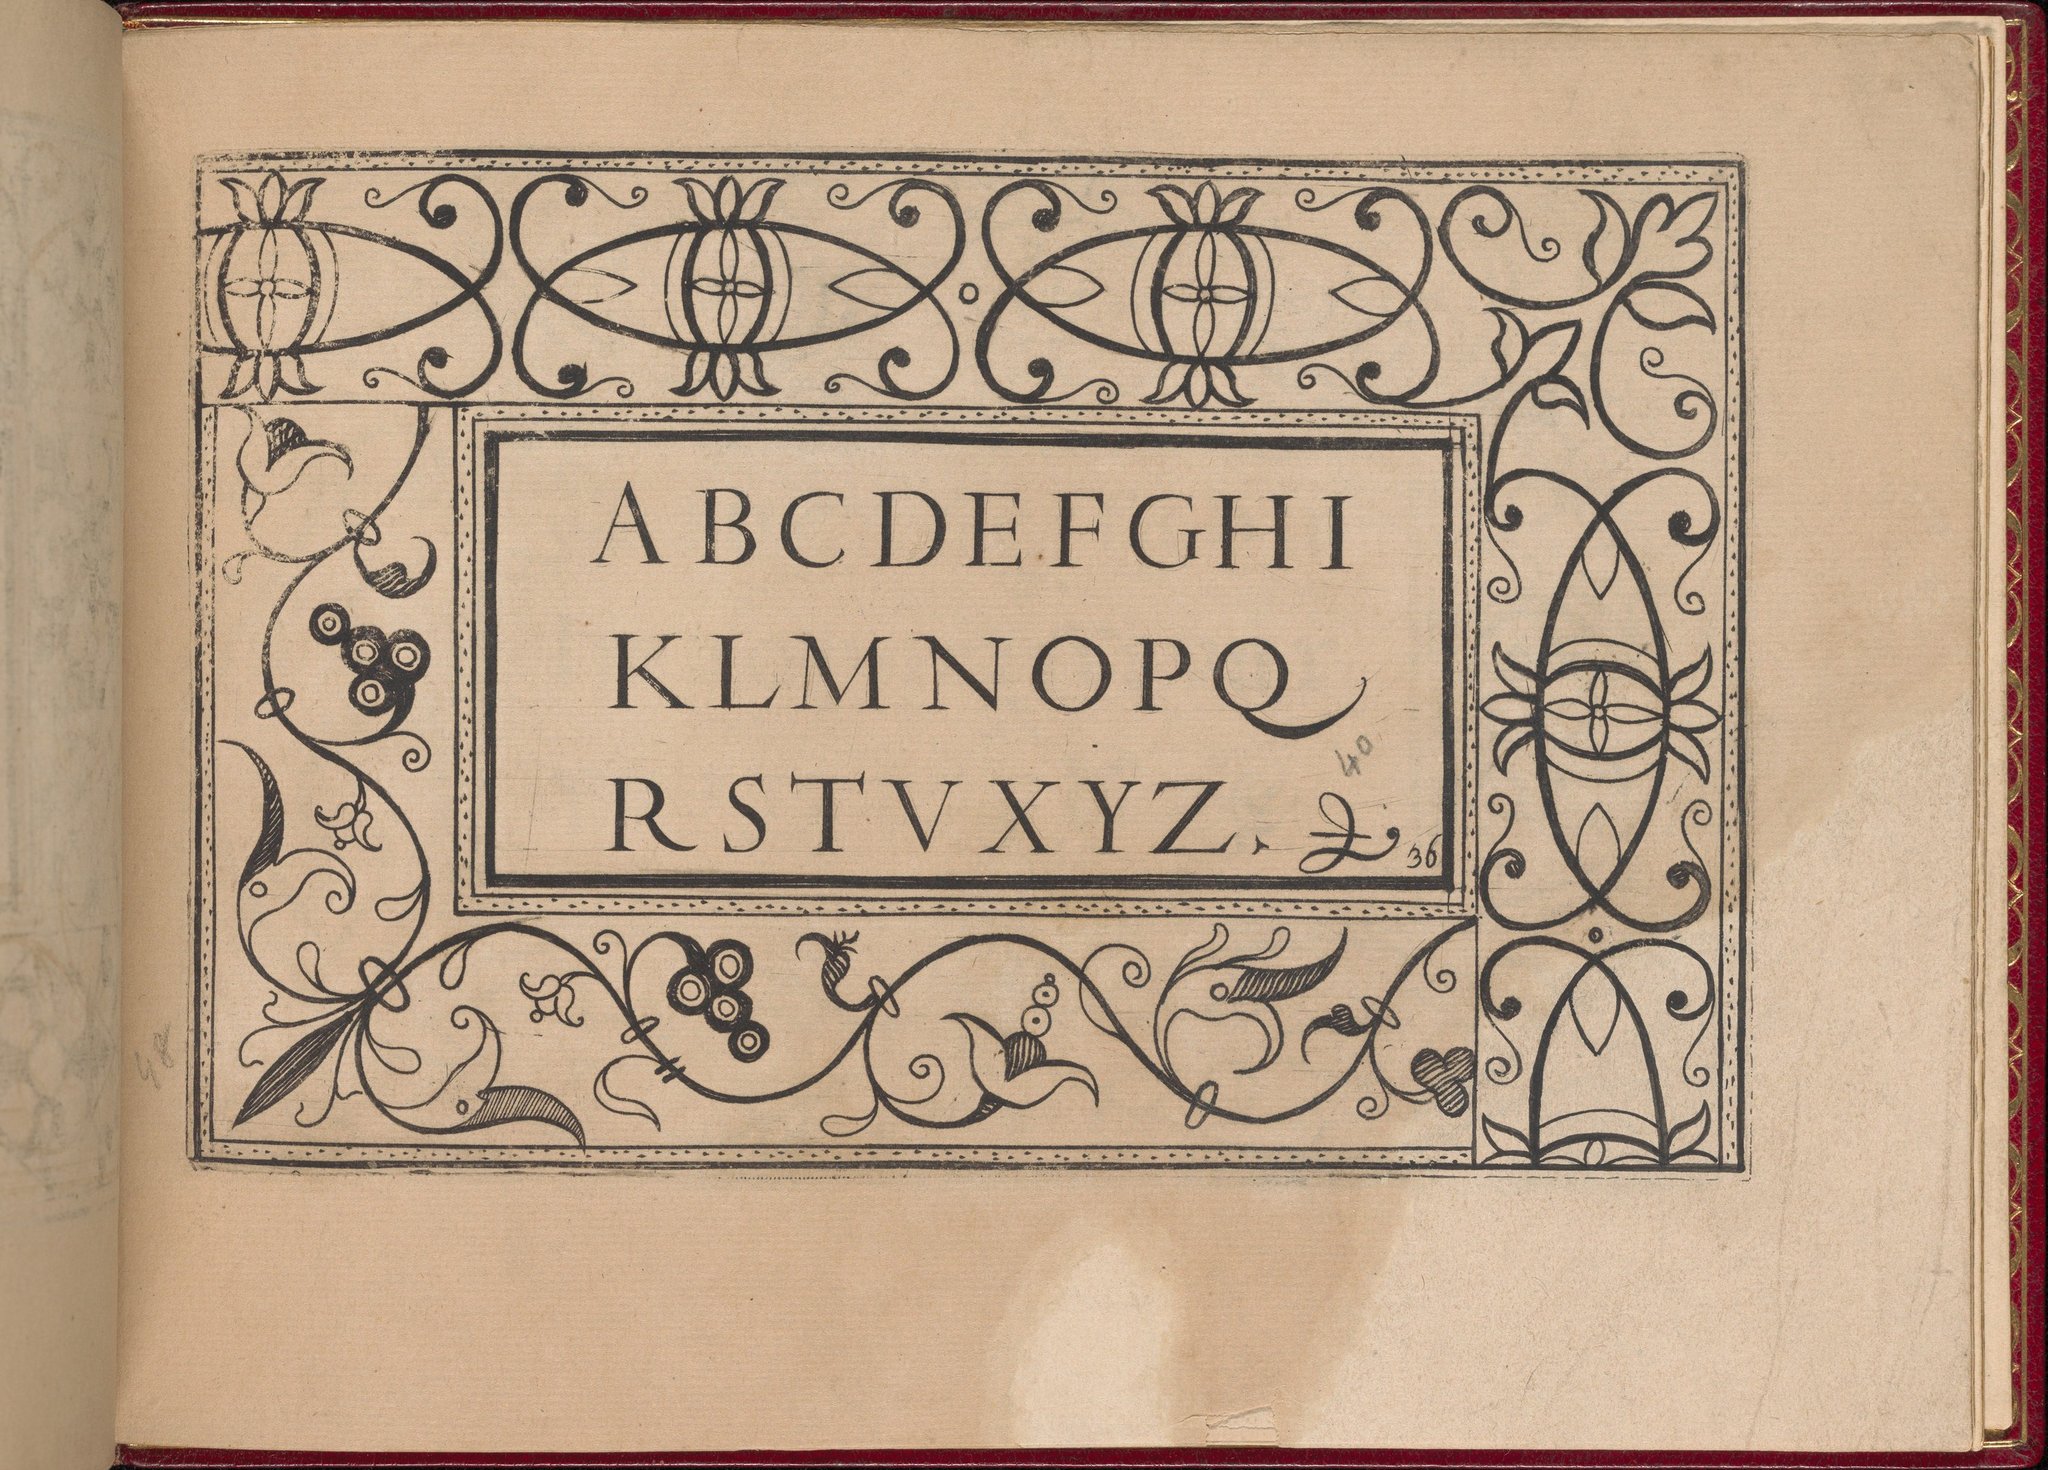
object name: book print ornament architecture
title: Ghirlanda: Di sei vaghi fiori scielti da piu famosi Giardini d'Italia, page 48 (recto)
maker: pietro paulo tozzi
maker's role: designer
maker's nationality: italian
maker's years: 1593-1628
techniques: drawing, etching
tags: flowers